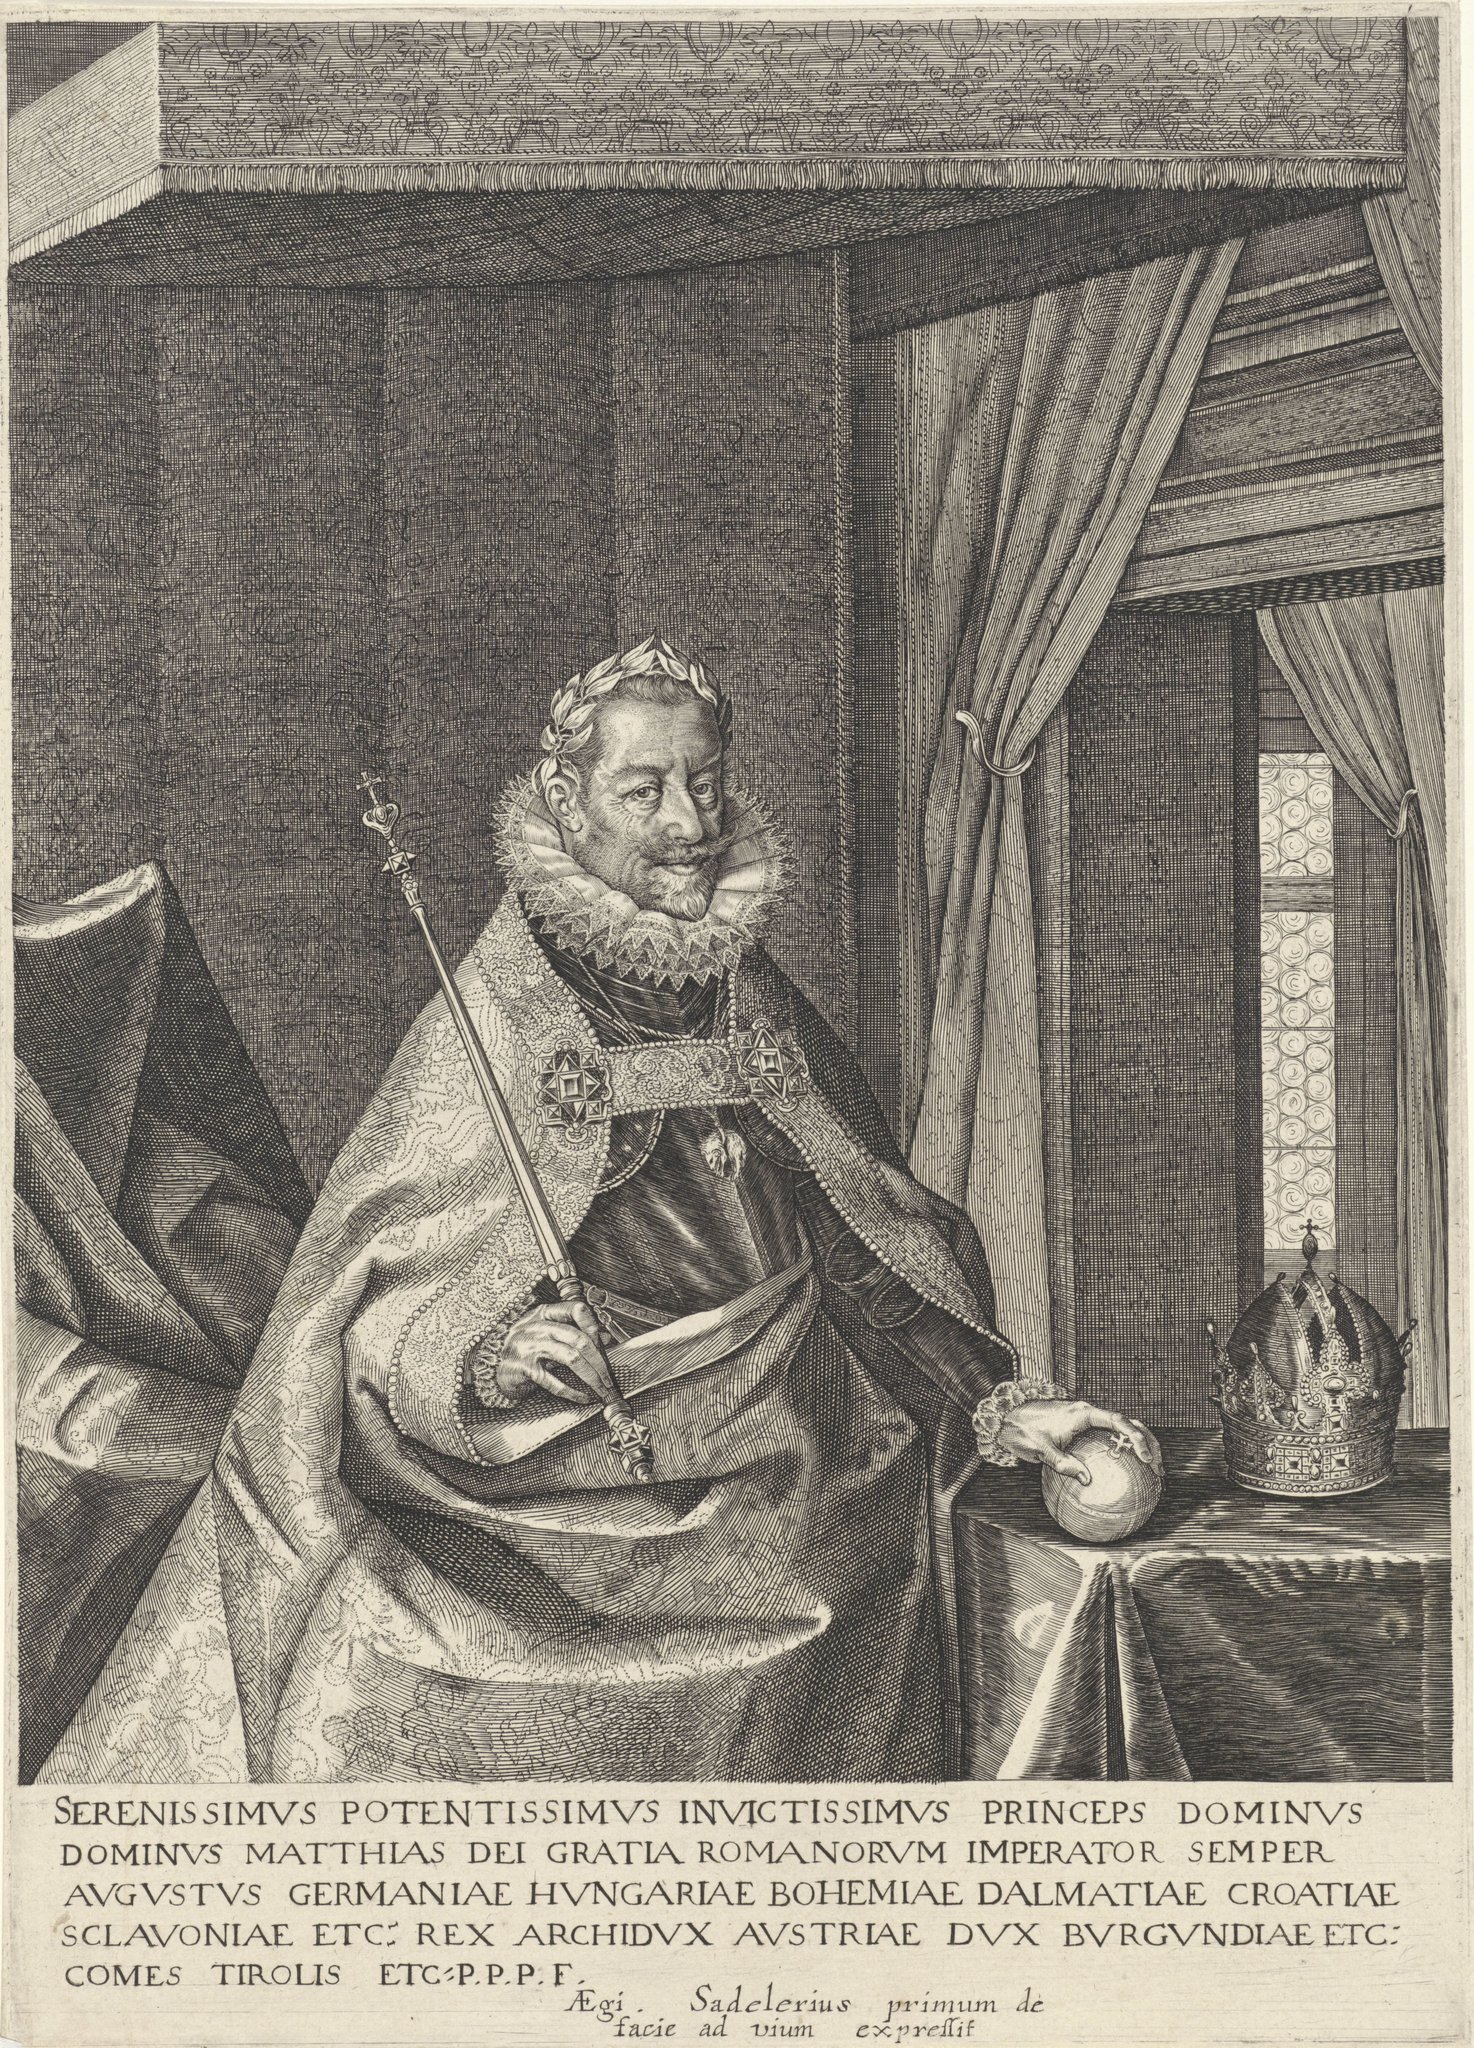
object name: print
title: Portret van keizer Matthias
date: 1616-1679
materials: paper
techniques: engraving, etching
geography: prague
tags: vienna, matthias van oostenrijk (rooms-duits keizer), crown (symbol of sovereignty), orb (symbol of sovereignty; sphere with cross on top), sceptre, staff (symbol of sovereignty), emperor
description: Matthias van Oostenrijk, keizer van het Heilig Roomse Rijk. Hij houdt in zijn linkerhand de rijksappel vast. In zijn rechterhand de keizerlijke scepter. Op een tafel naast hem de keizerlijke kroon.